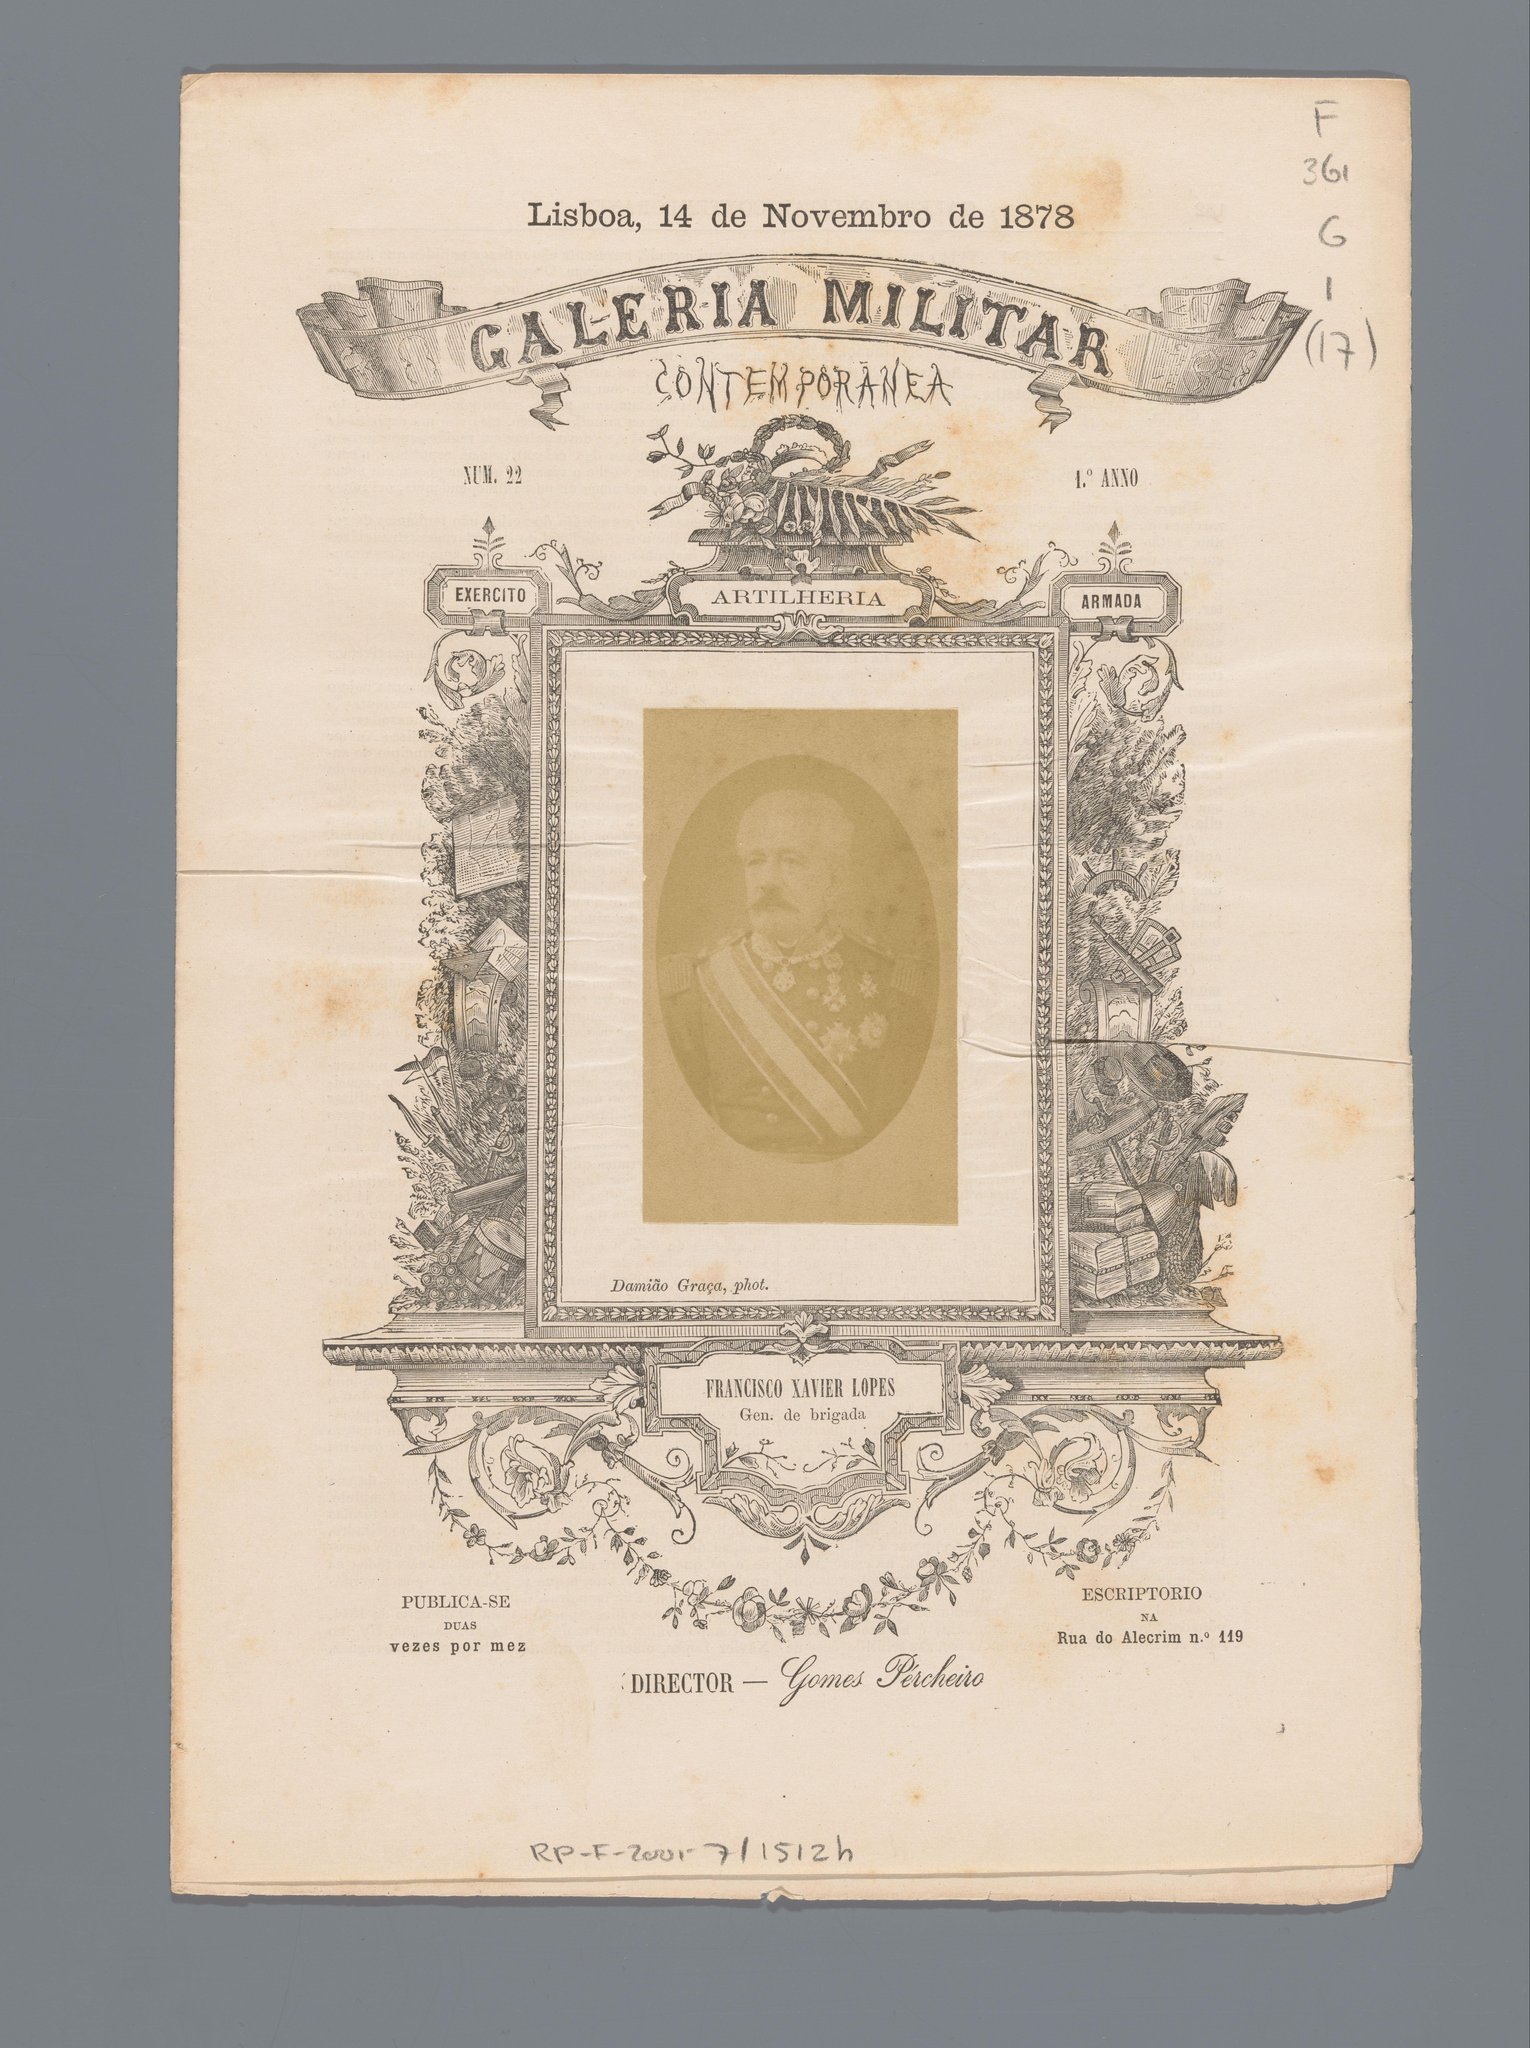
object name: page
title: Francisco Xavier Lopes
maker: damião da graça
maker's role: fotograaf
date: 1873-1878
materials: photographic support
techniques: albumen print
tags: historical persons, commander-in-chief, admiral